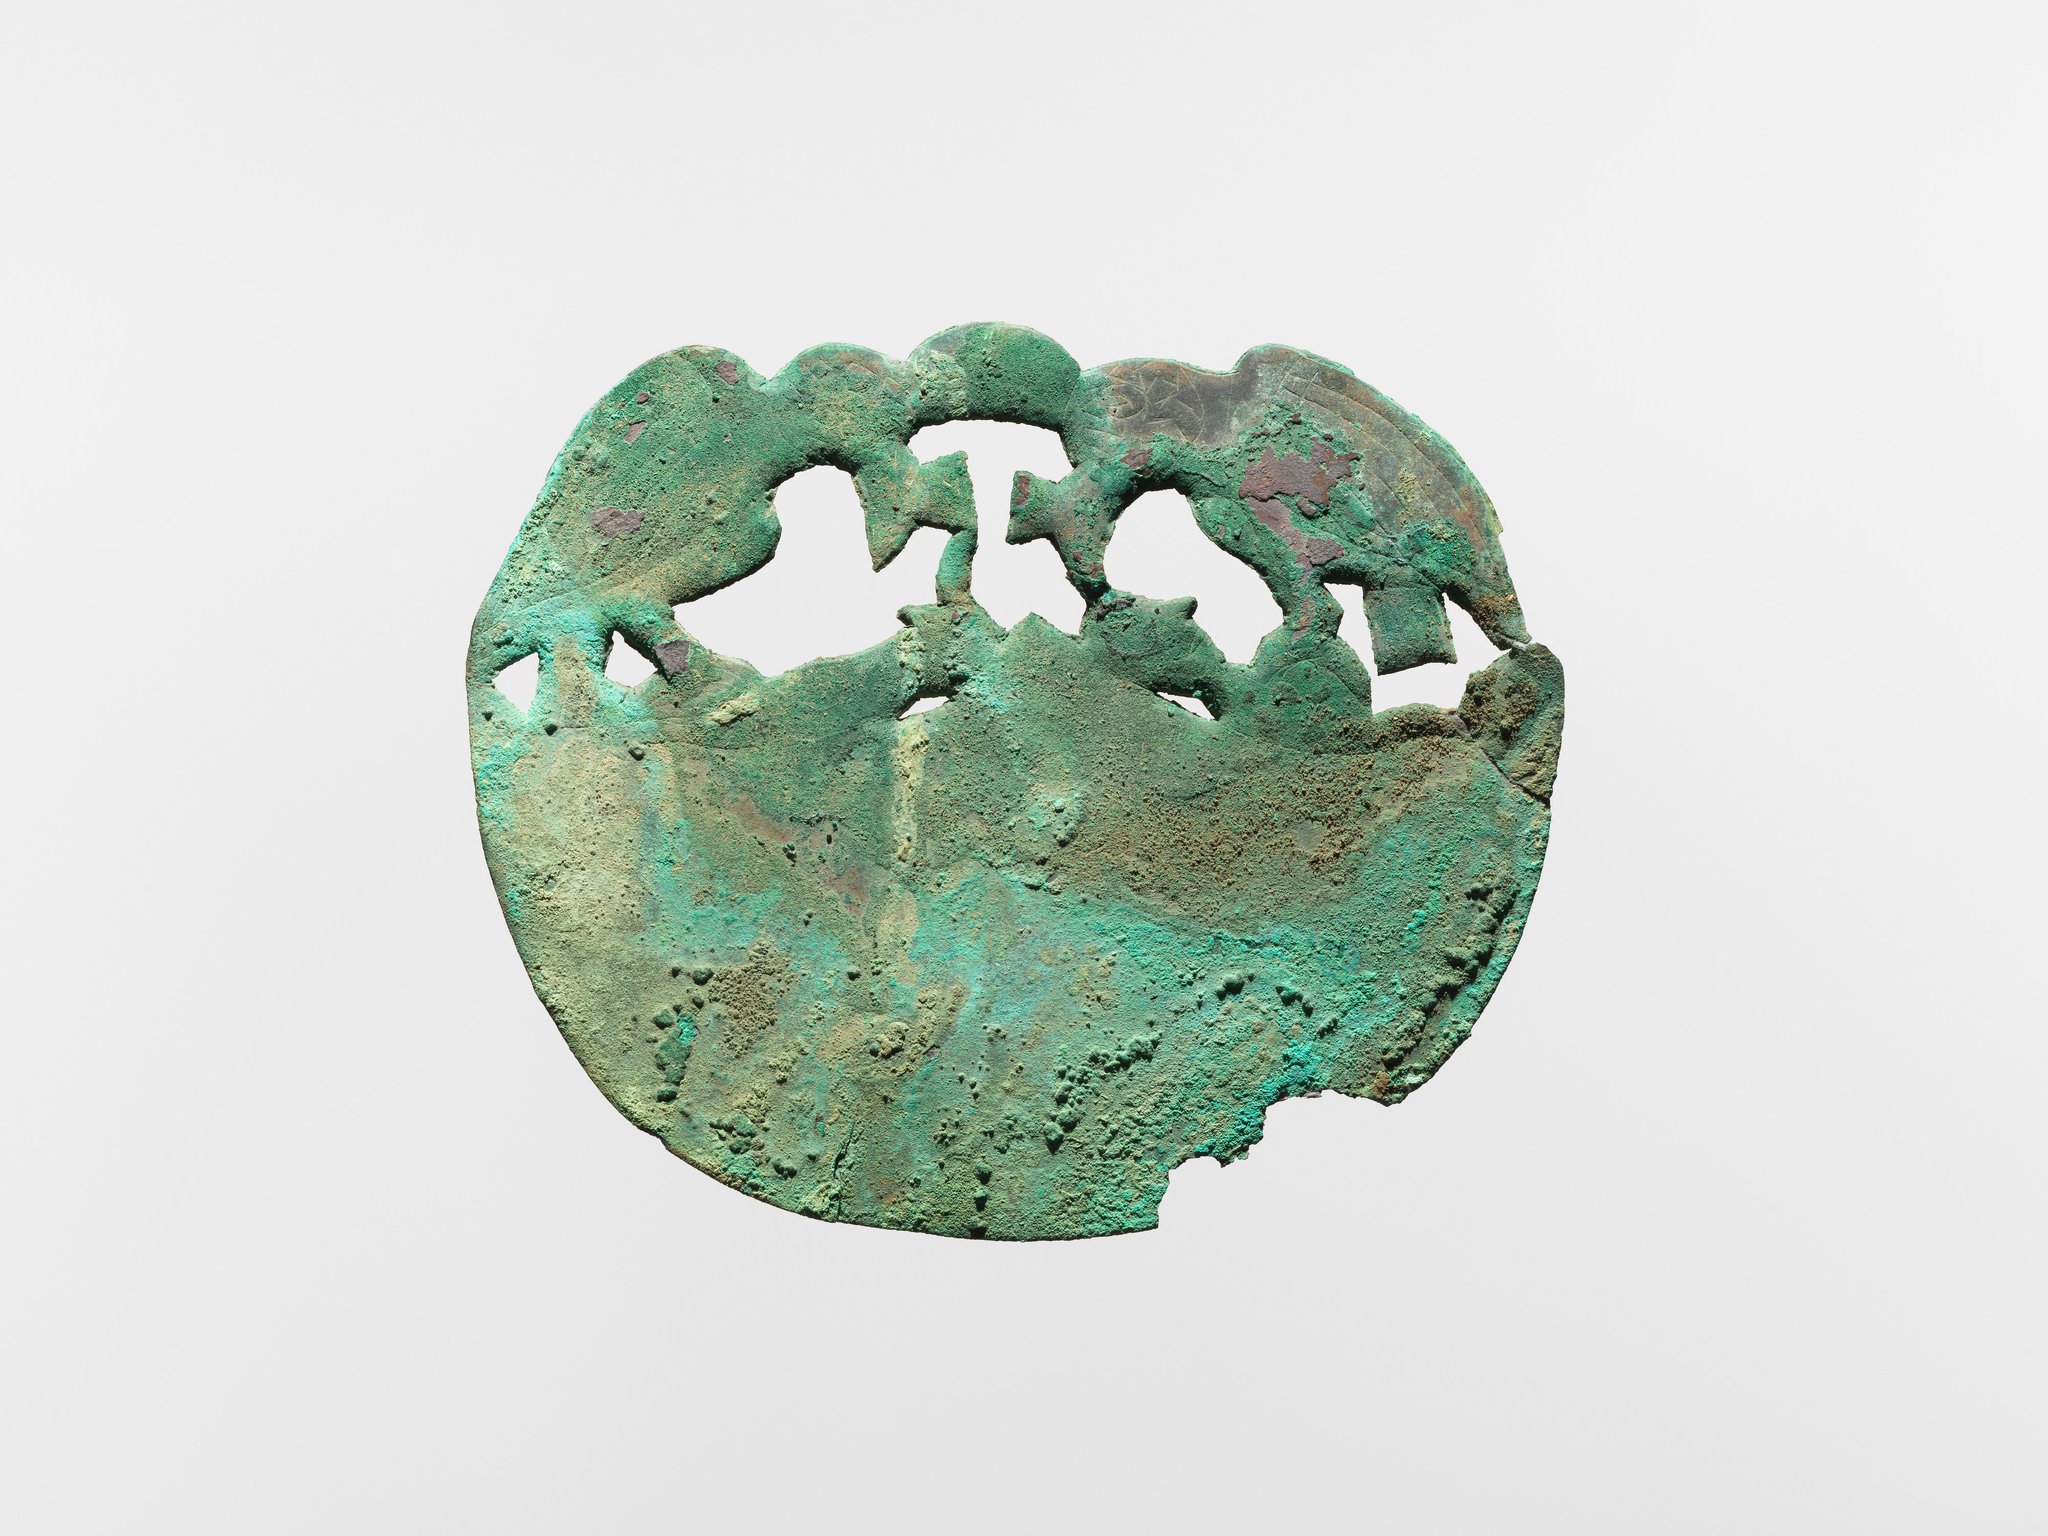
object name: ornament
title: Animal Ornament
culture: moche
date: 501-700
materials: copper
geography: peru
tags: animals